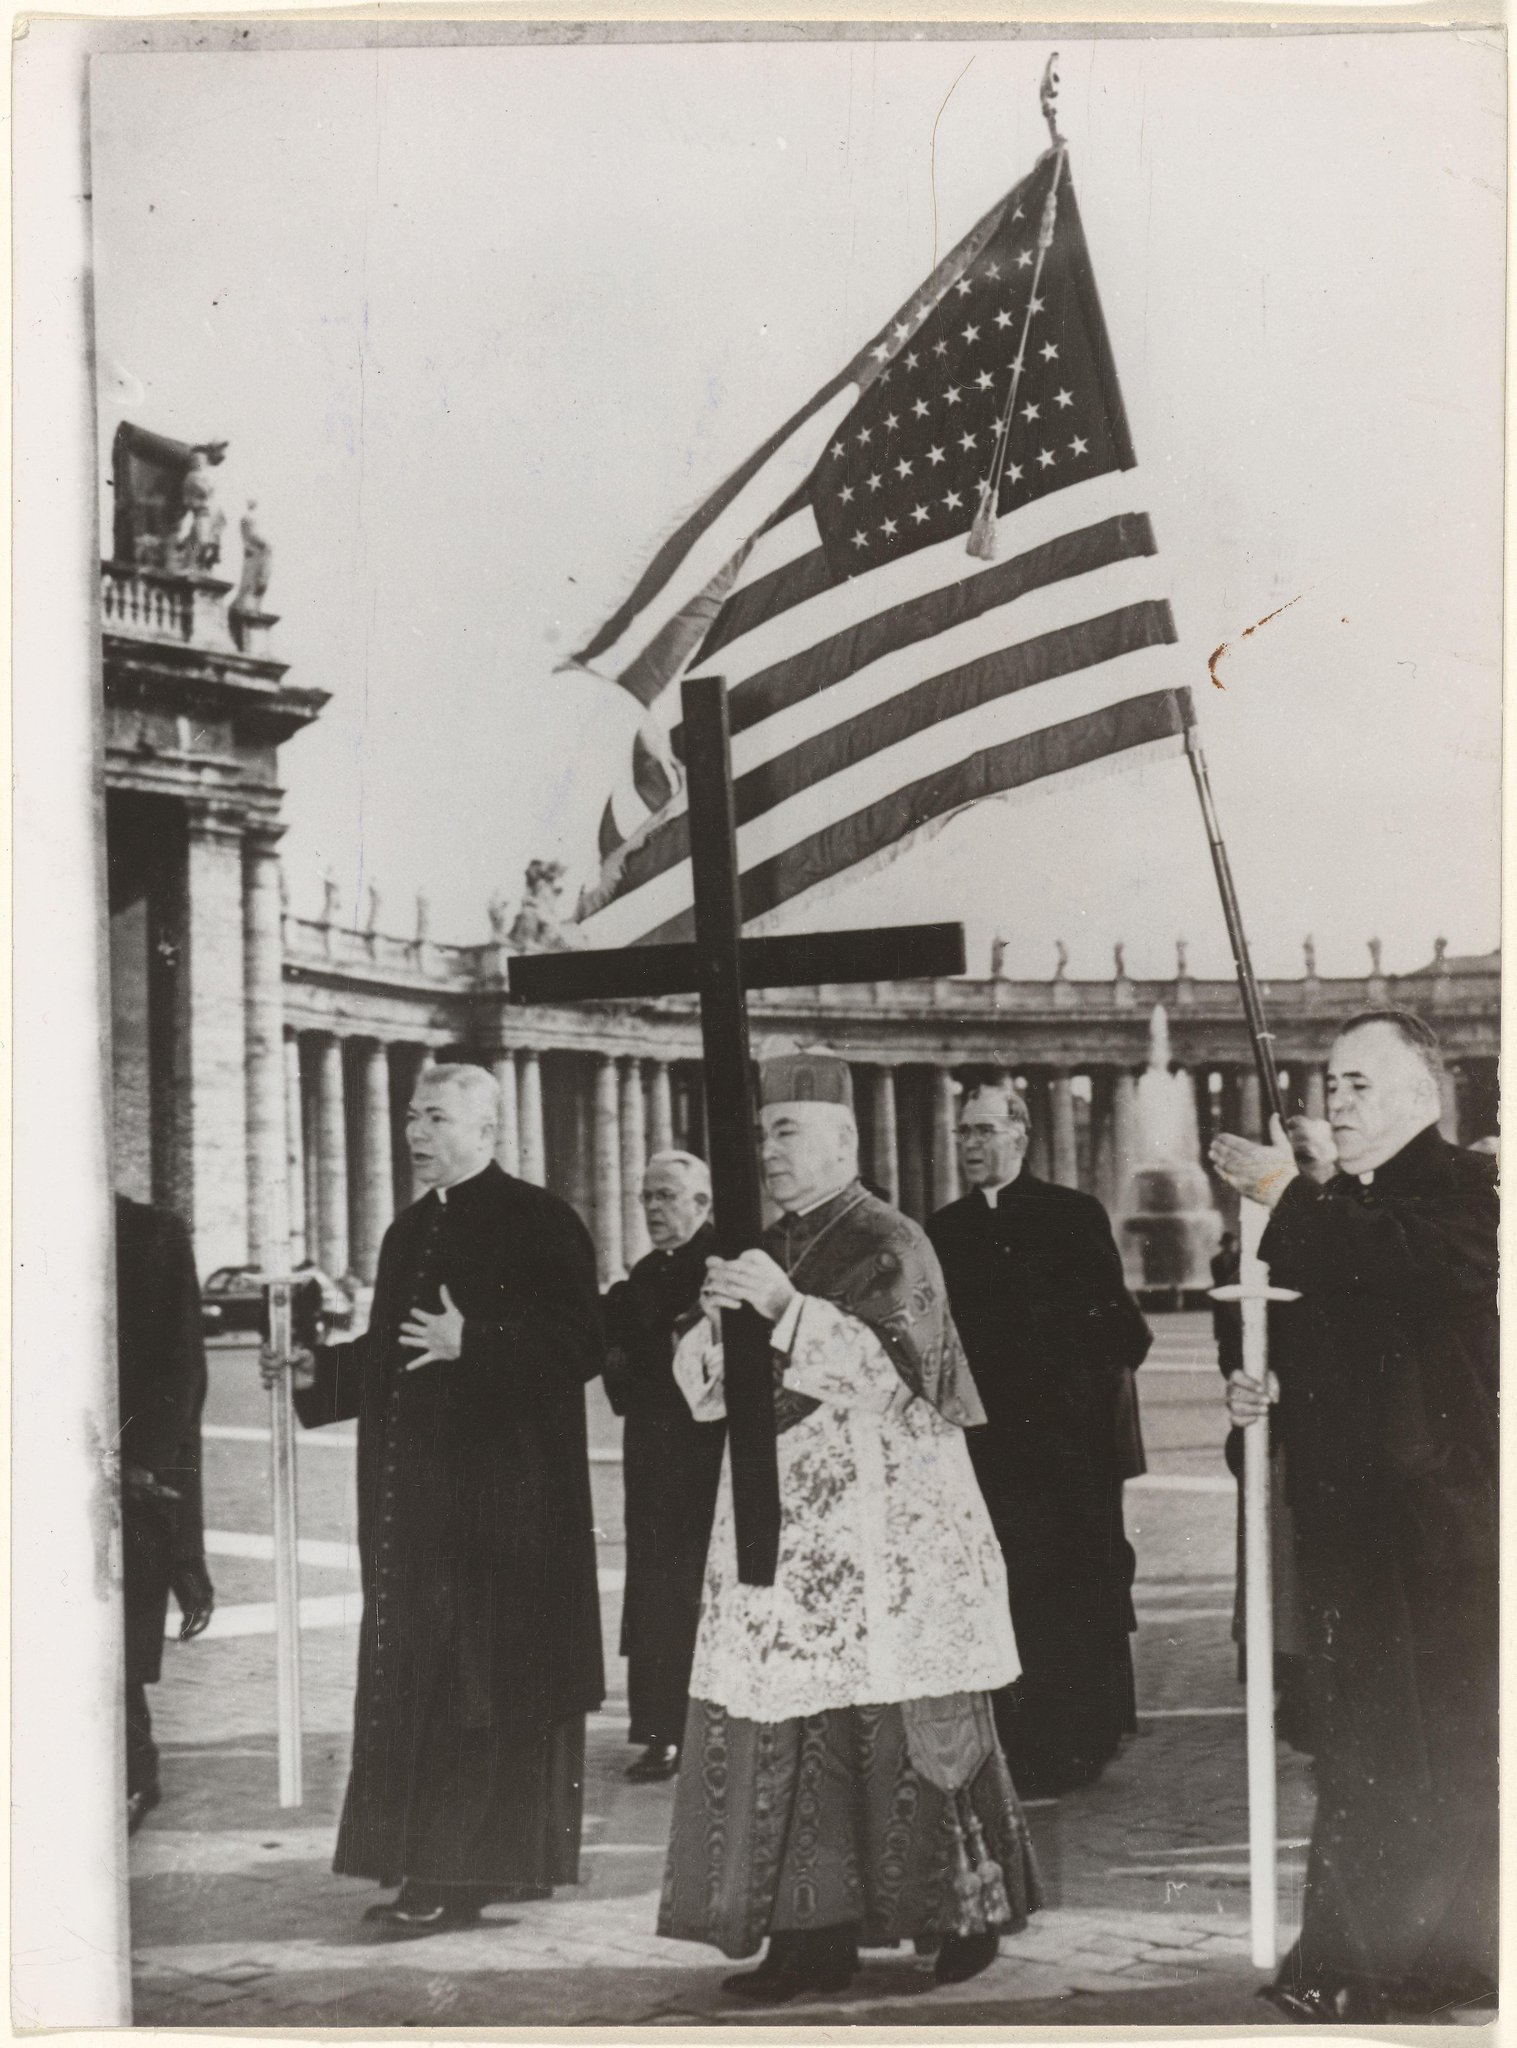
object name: photograph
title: Kardinaal Spellman leidt New Yorkse pelgrims in St. Peter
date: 1950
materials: photographic support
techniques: gelatin silver print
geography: london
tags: kardinaal, francis joseph spellman, sint-pietersbasiliek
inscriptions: inscription: ‘Cardinal Spellman of New York ... into the holy door at St Perer's’